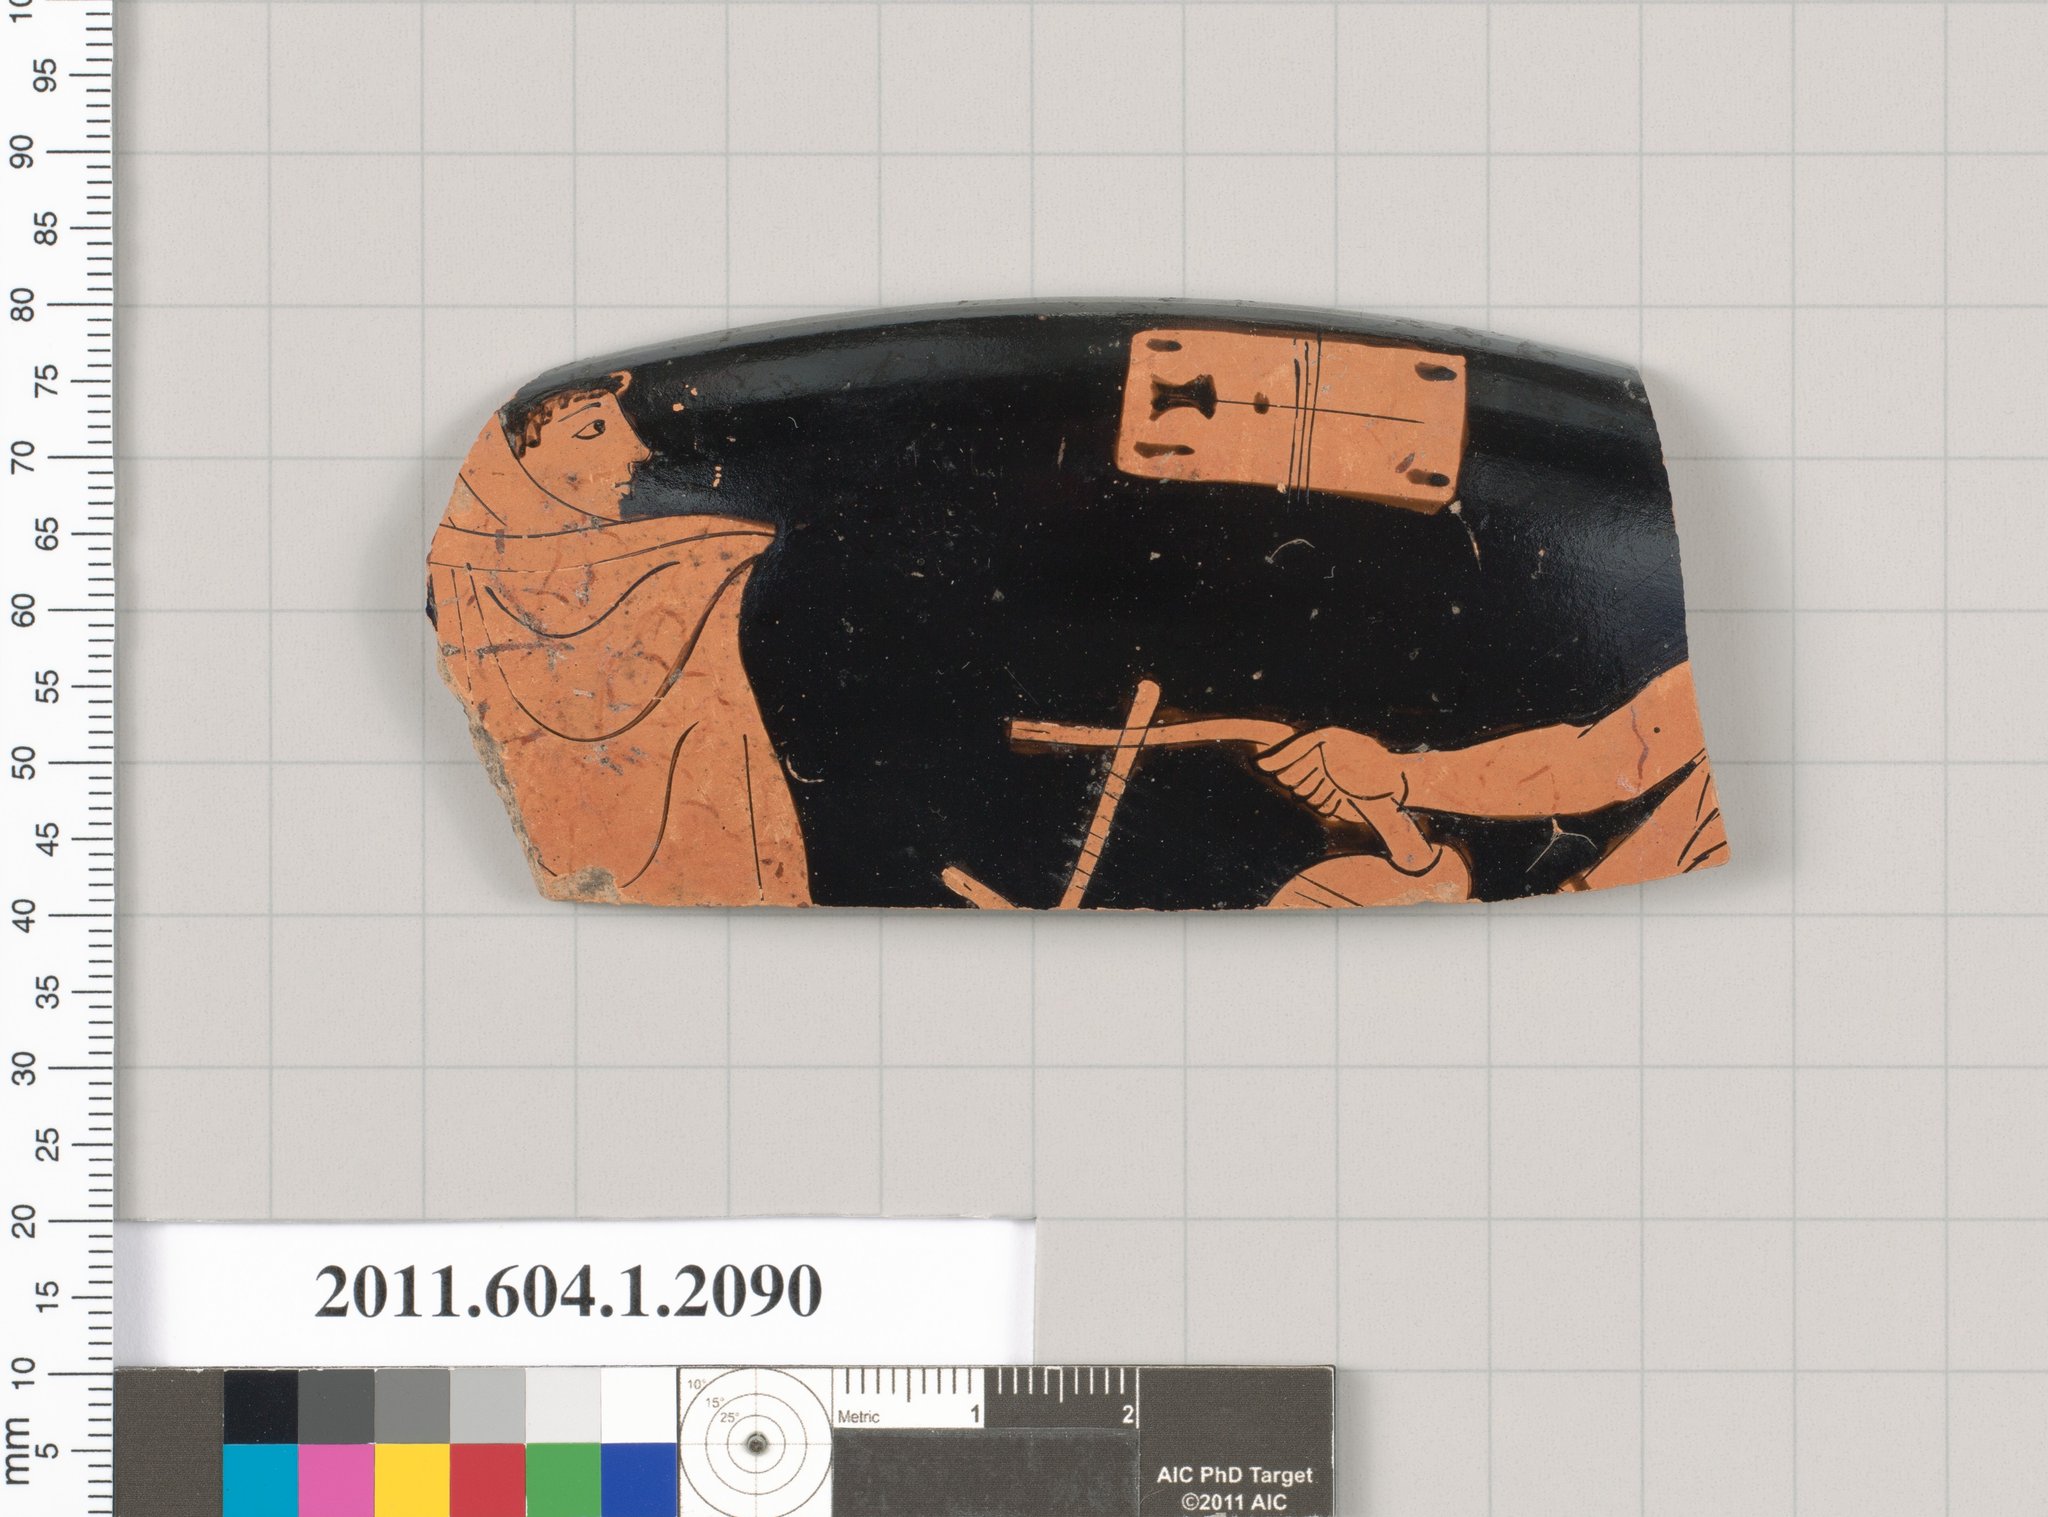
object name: kylix fragment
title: Terracotta rim fragment of a kylix (drinking cup)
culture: greek, attic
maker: telephos painter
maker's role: artist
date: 480-470 BCE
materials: terracotta